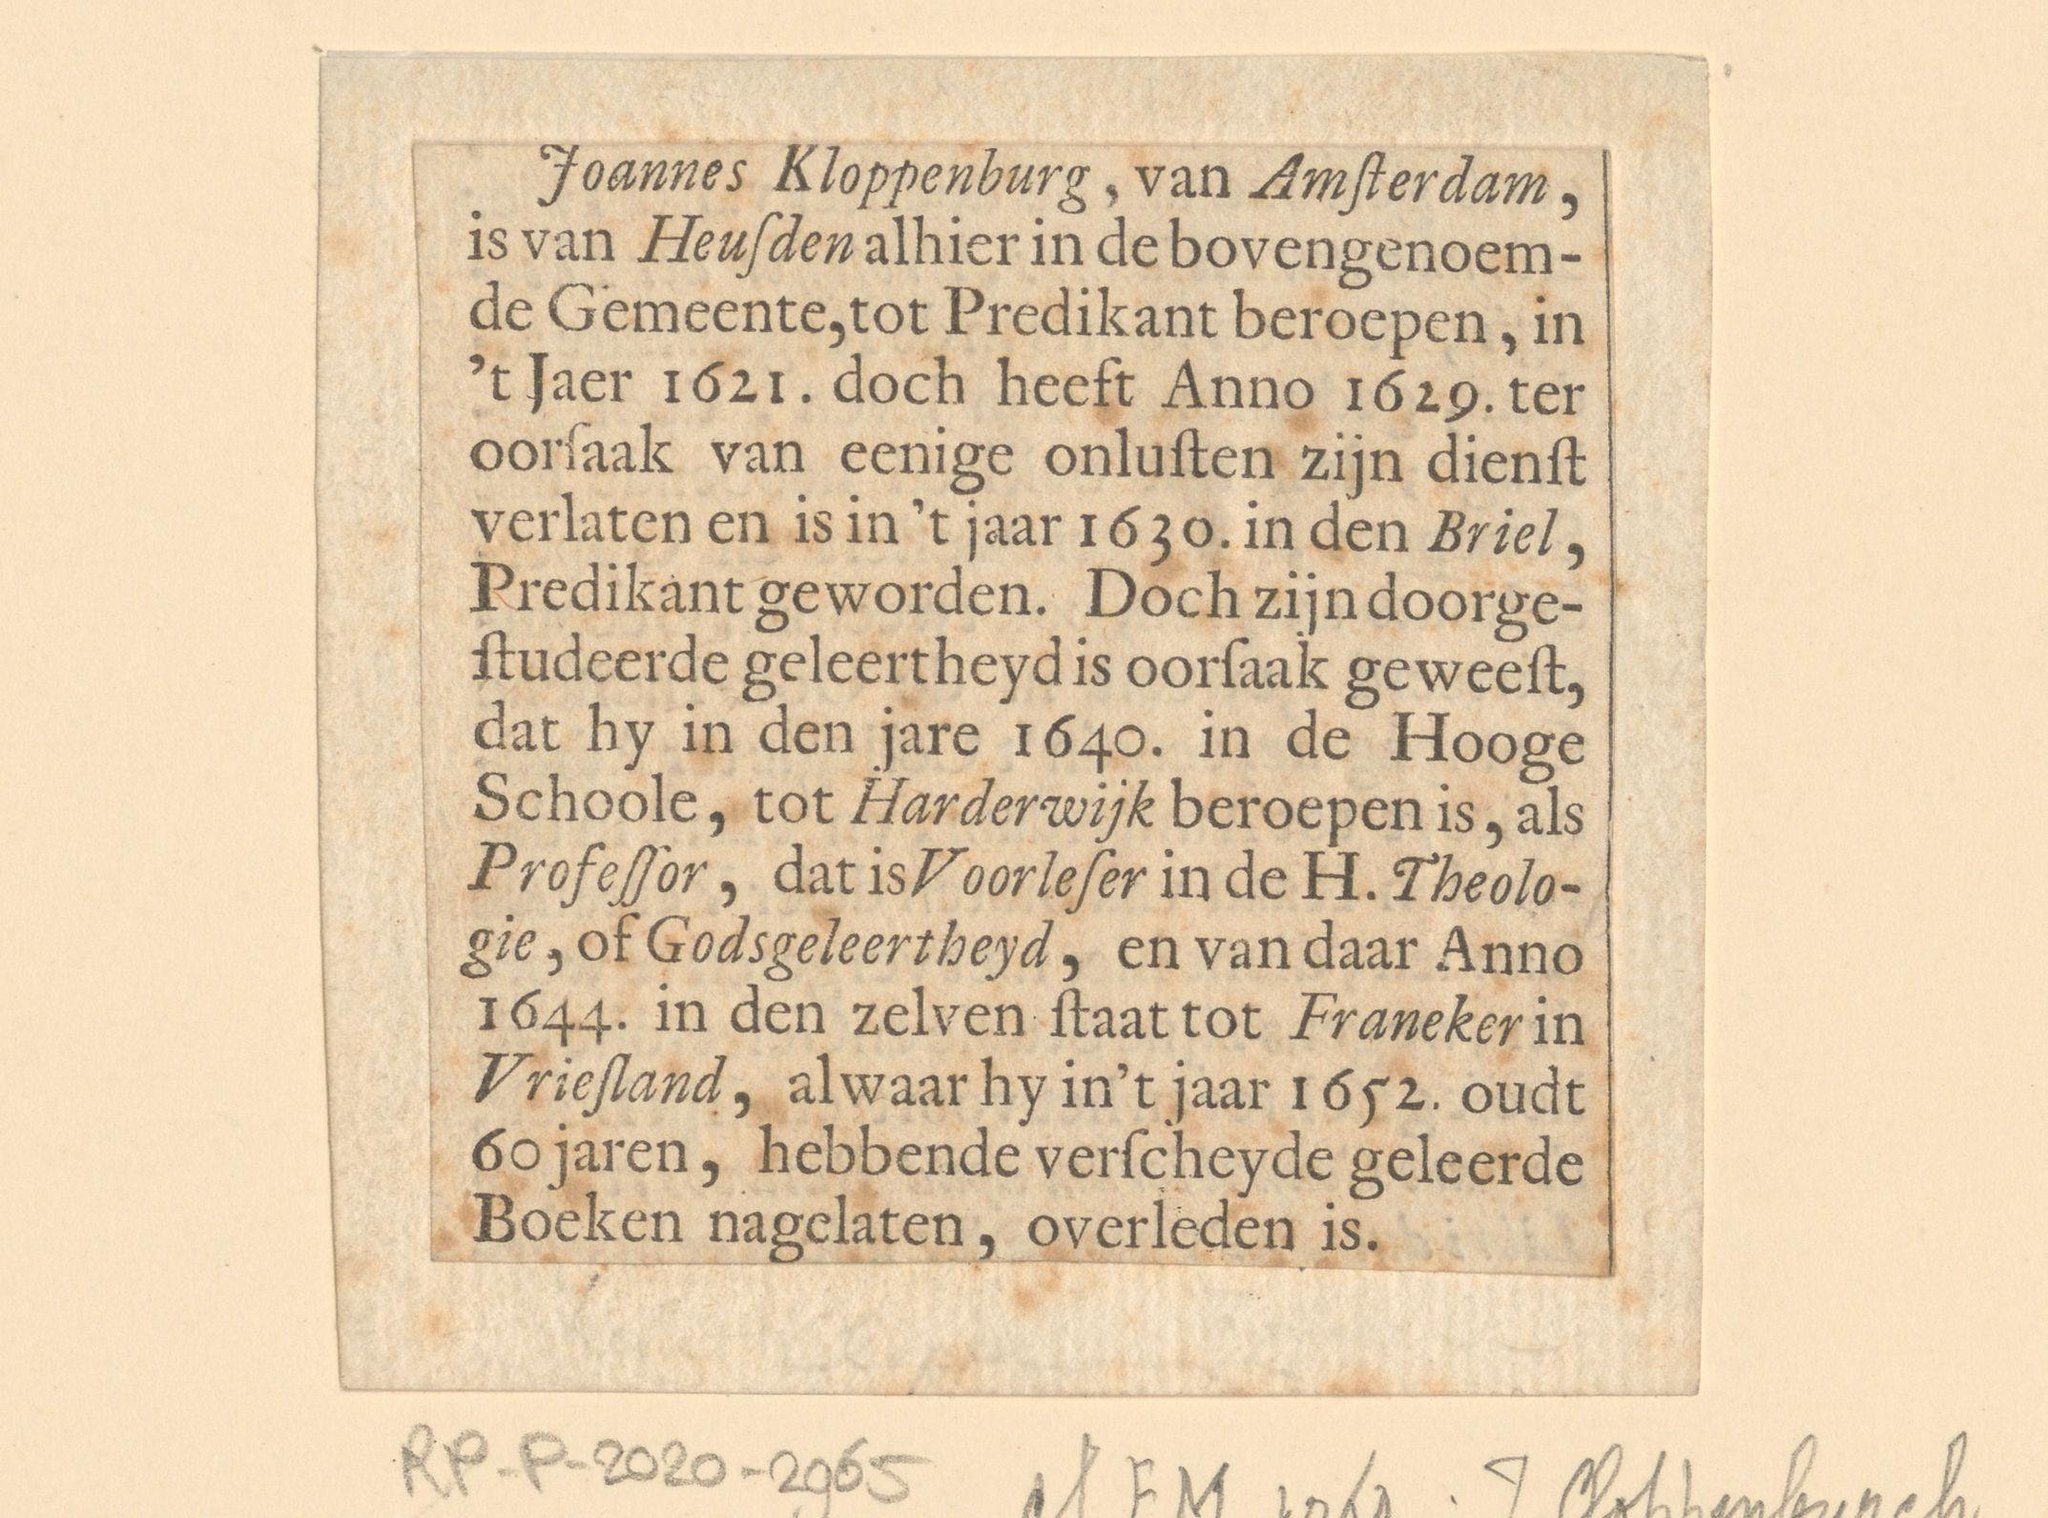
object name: text sheet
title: Biografie van Johannes Cloppenburg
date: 1726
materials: paper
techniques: letterpress printing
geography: amsterdam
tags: amsterdam, historical persons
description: Tekstblad uit: Commelin, Caspar. Beschryvinge van Amsterdam, zynde een naukeurige verhandelinge van desselfs eerste oorspronk uyt den Huyse der heeren van Amstel (...) Amsterdam: Andries van Damme, Johannes Ratelband I, weduwe Antony van Aeltwijk en Hermanus Uytwerf, 1726, dl. 2.